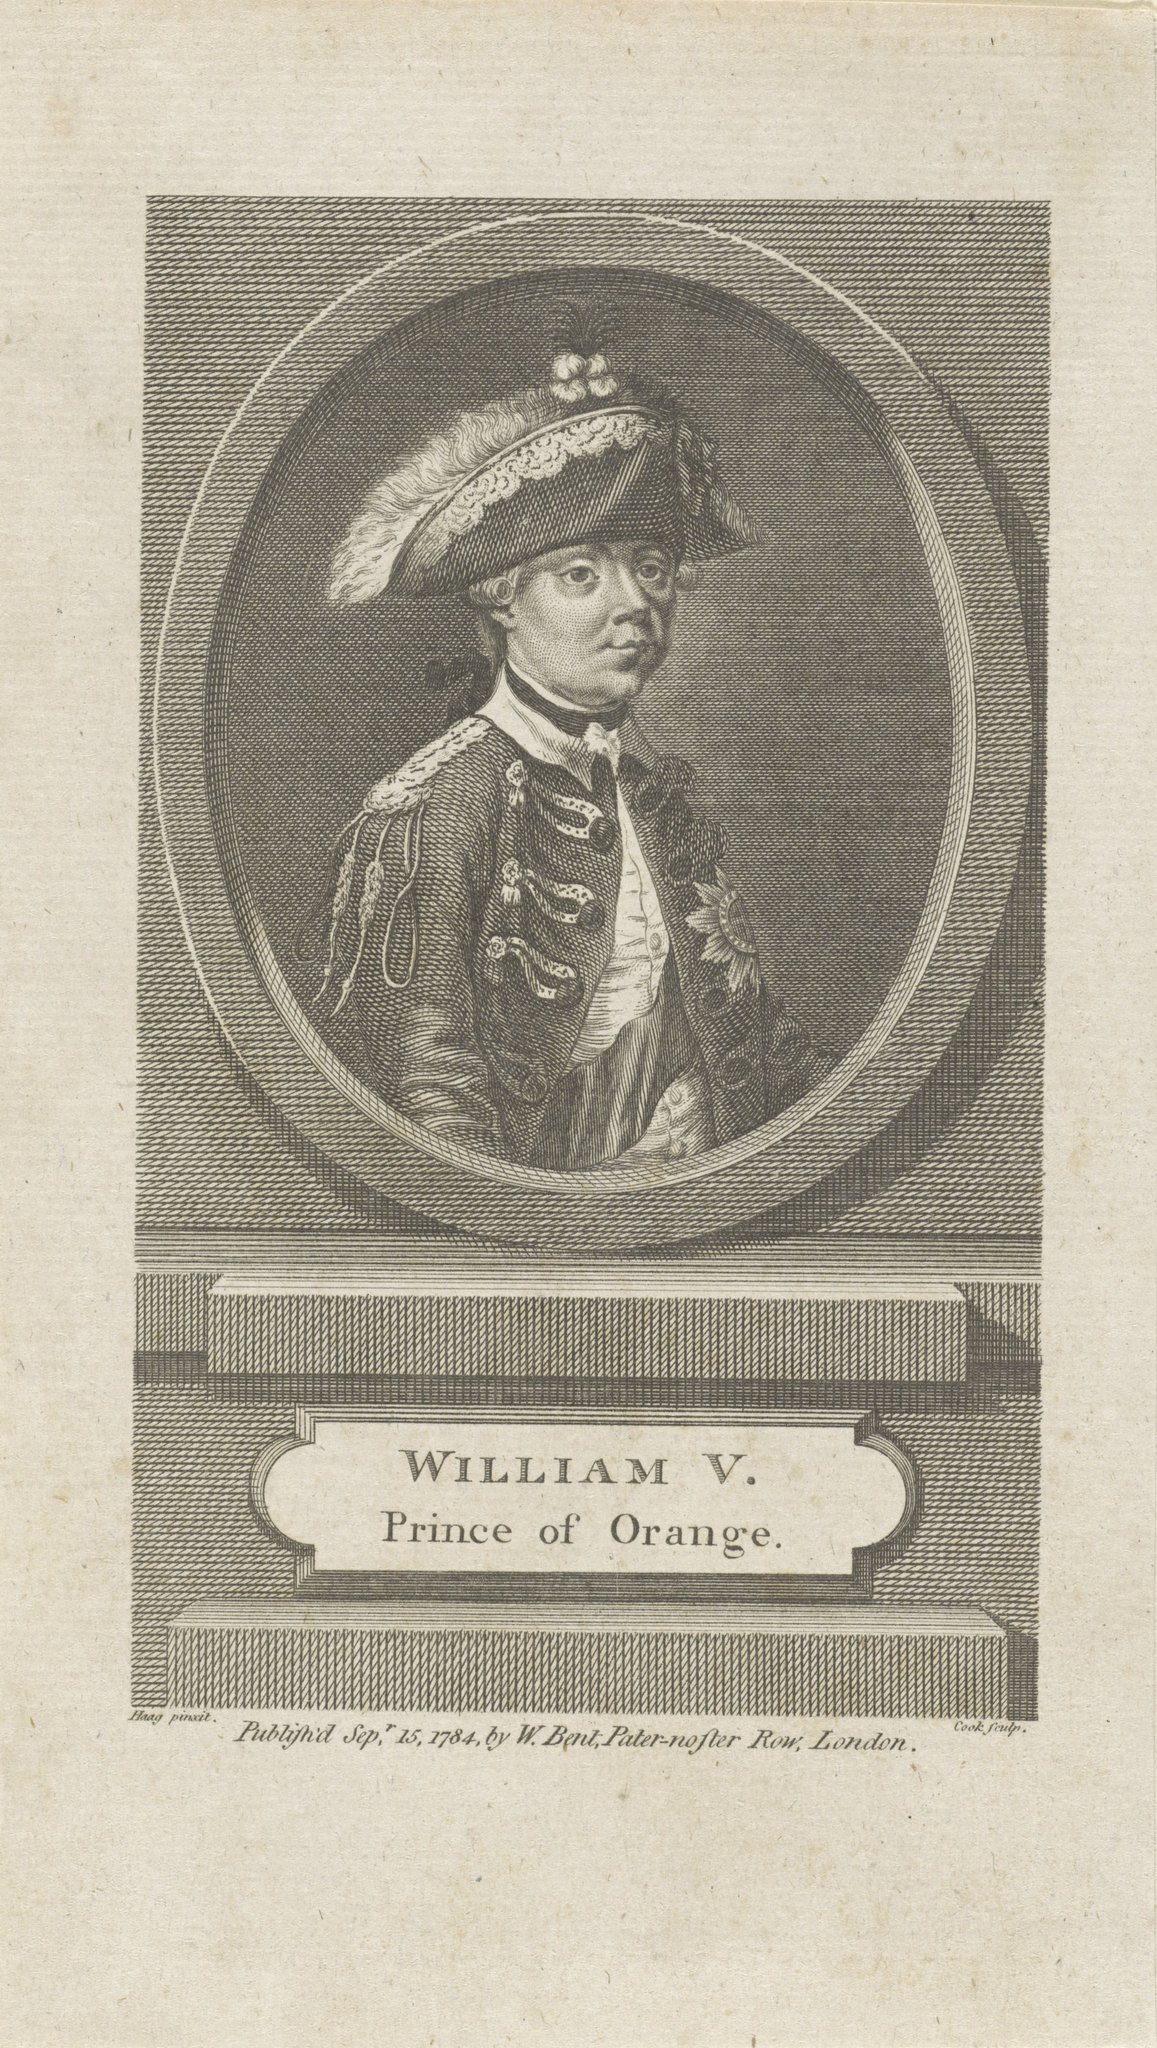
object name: print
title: Portret van Willem V, prins van Oranje-Nassau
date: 1784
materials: paper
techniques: engraving, etching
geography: london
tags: the hague, william v (prince of orange)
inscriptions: collector's mark: Lugt 2228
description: De hier vermelde titel verwijst naar de hoogst verkregen titel van de geportretteerde, niet per se naar de titel die de geportretteerde op deze voorstelling draagt.